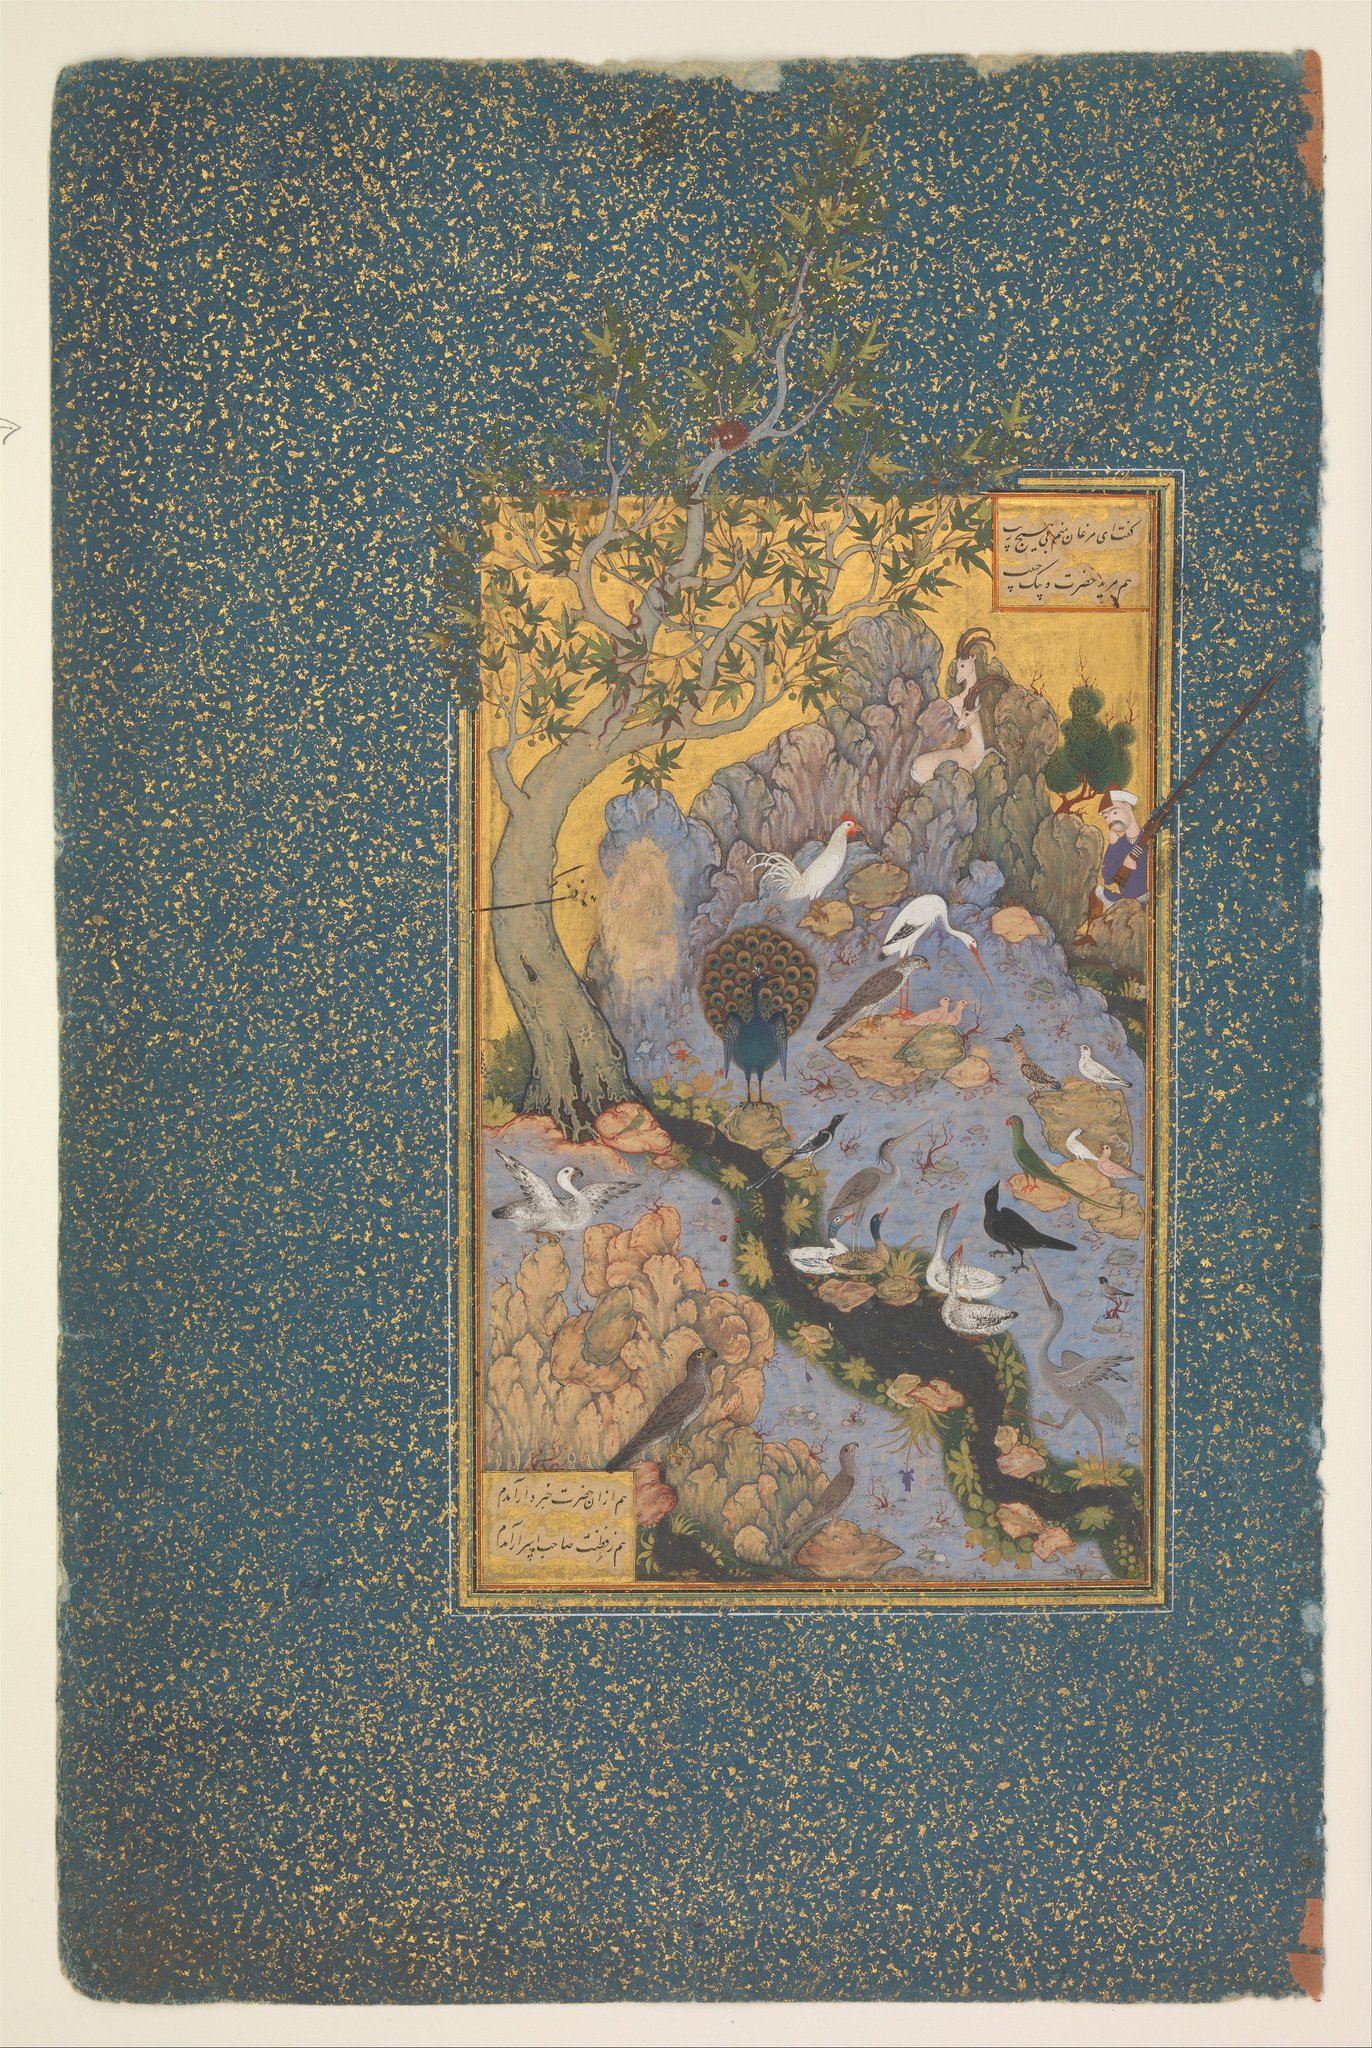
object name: folio from an illustrated manuscript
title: "The Concourse of the Birds", Folio 11r from a Mantiq al-Tayr (Language of the Birds)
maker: habiballah of sava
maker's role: artist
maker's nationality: iranian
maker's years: 1565-1635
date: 1600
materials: gold, ink, paper, silver, watercolor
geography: iran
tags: cranes,ducks,poetry,men,persian,peacocks,roosters